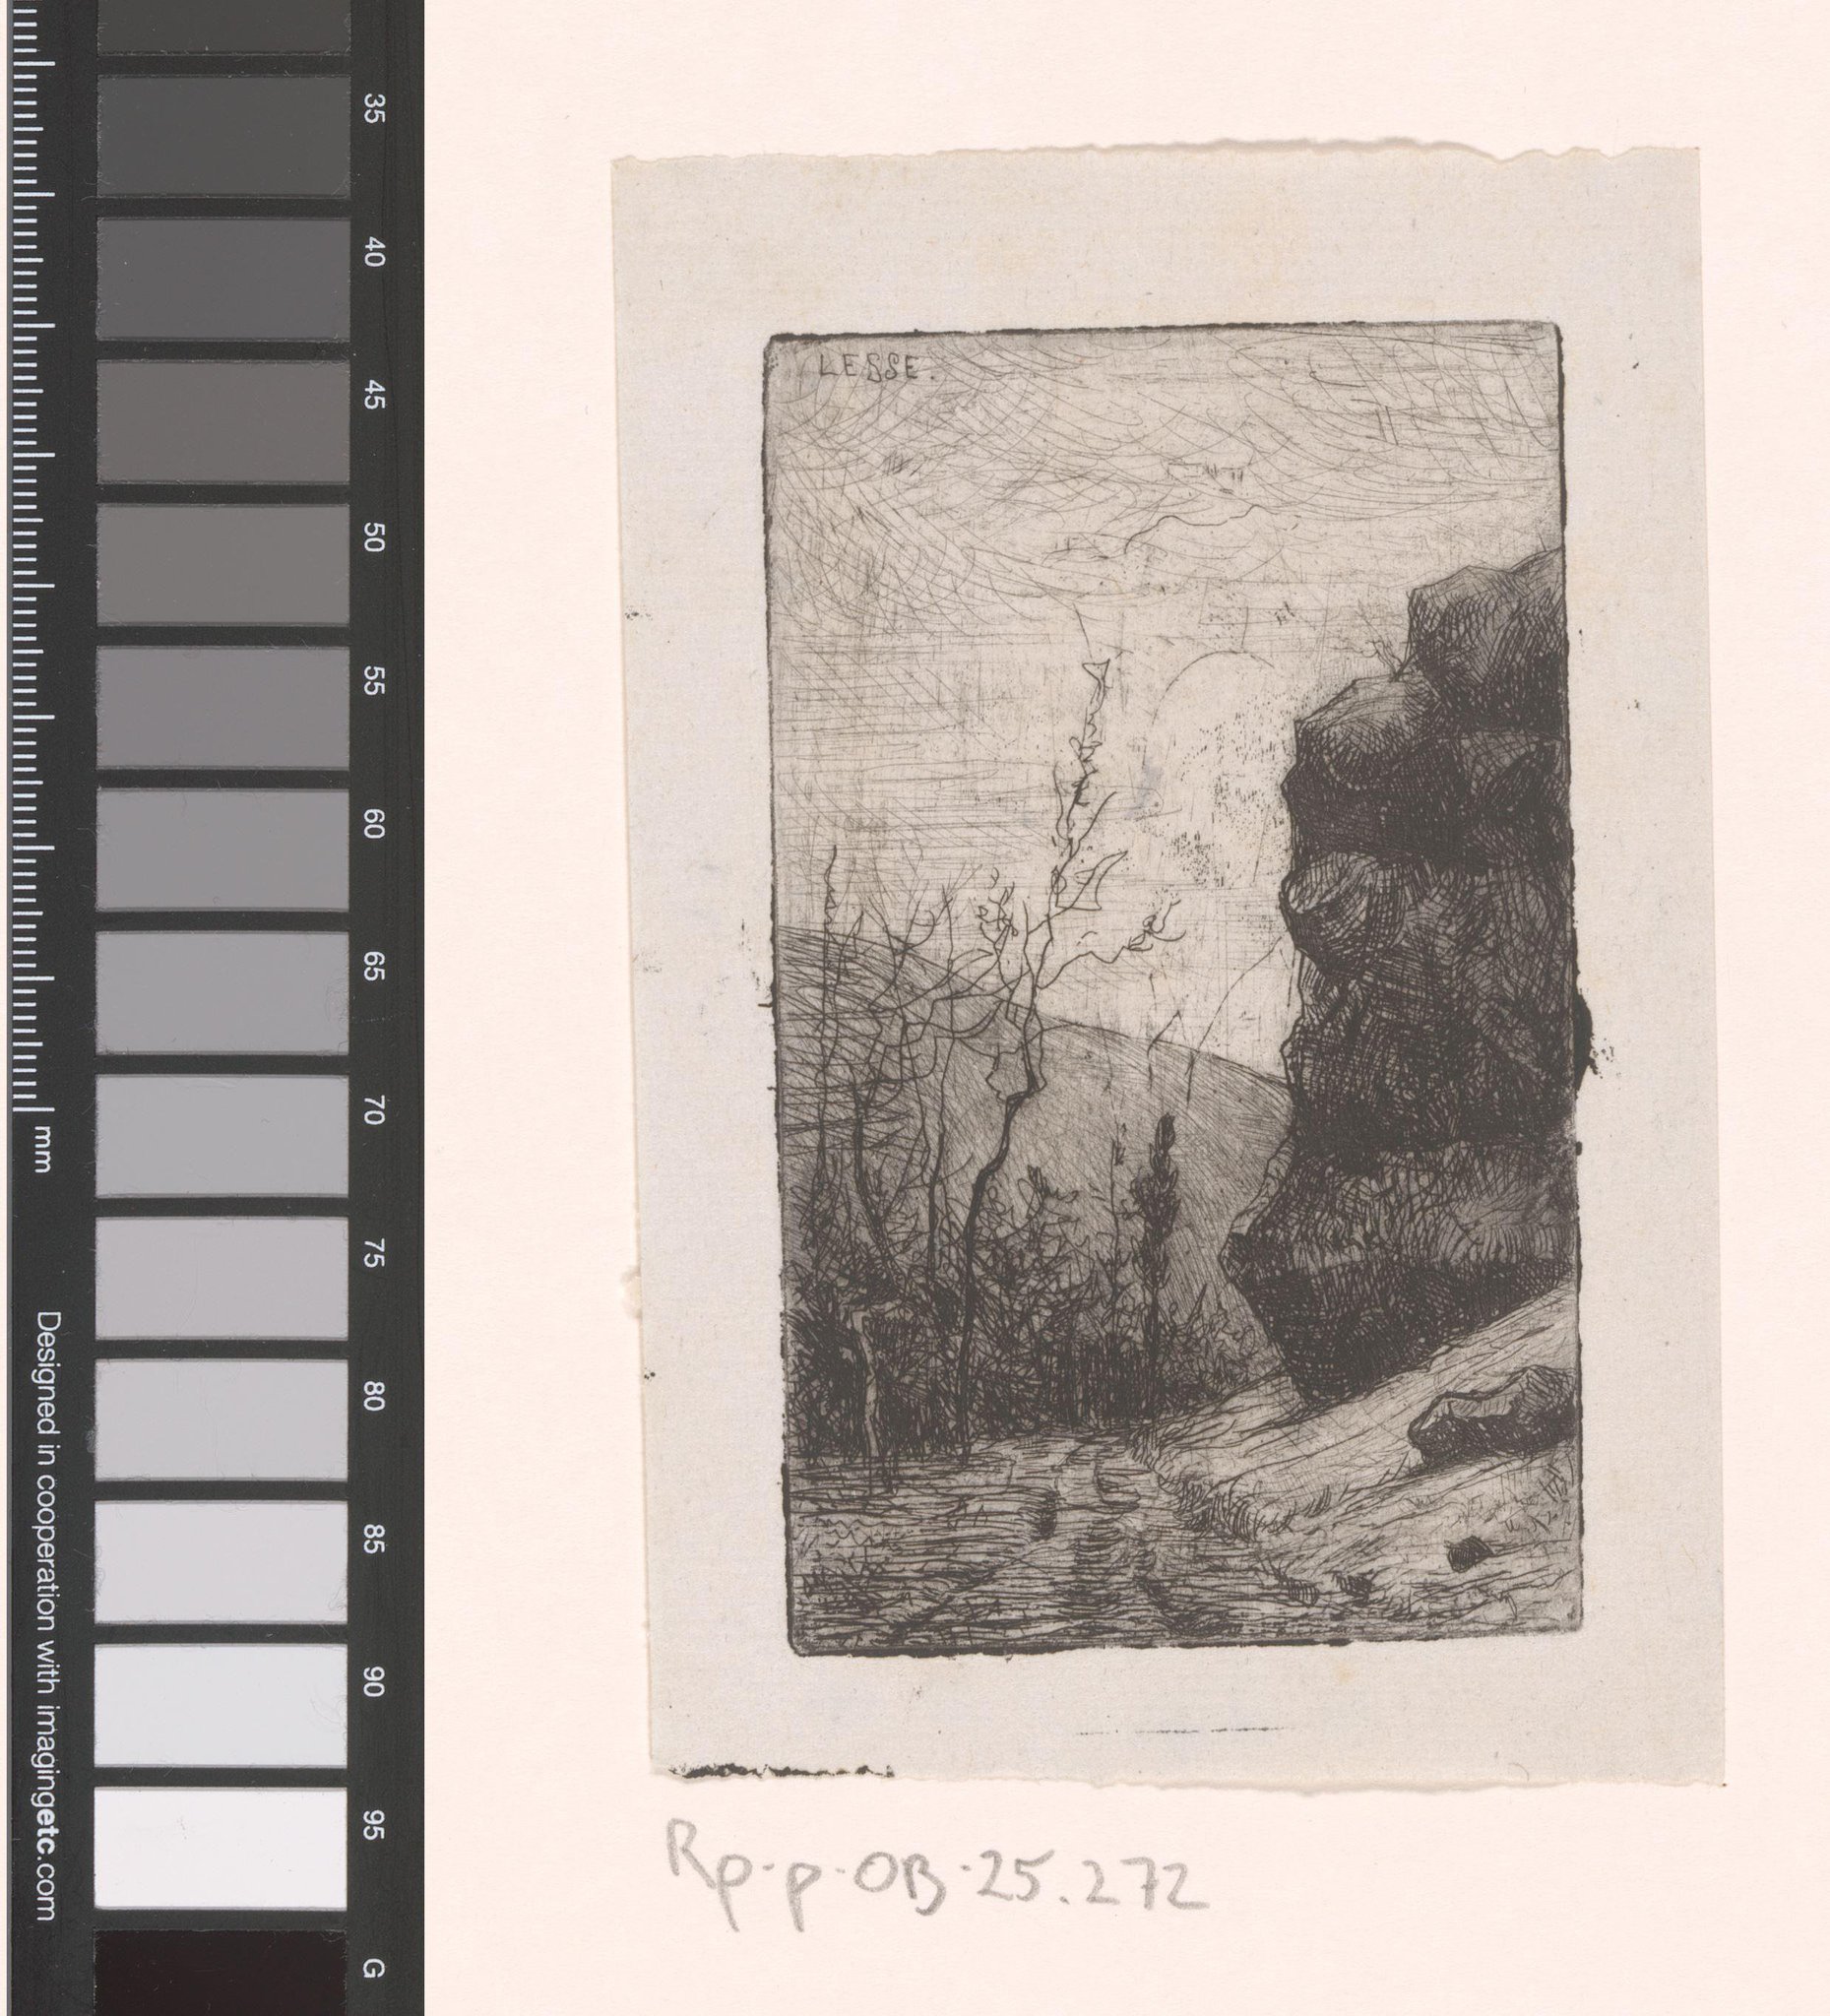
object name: print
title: Lesse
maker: philip zilcken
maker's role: draughtsman, painter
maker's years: 1857-1930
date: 1867-1890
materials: paper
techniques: drypoint, etching, intaglio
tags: river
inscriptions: collector's mark: Lugt 2228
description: Gezicht op de rivier de Lesse, en rotsen langs de waterkant.